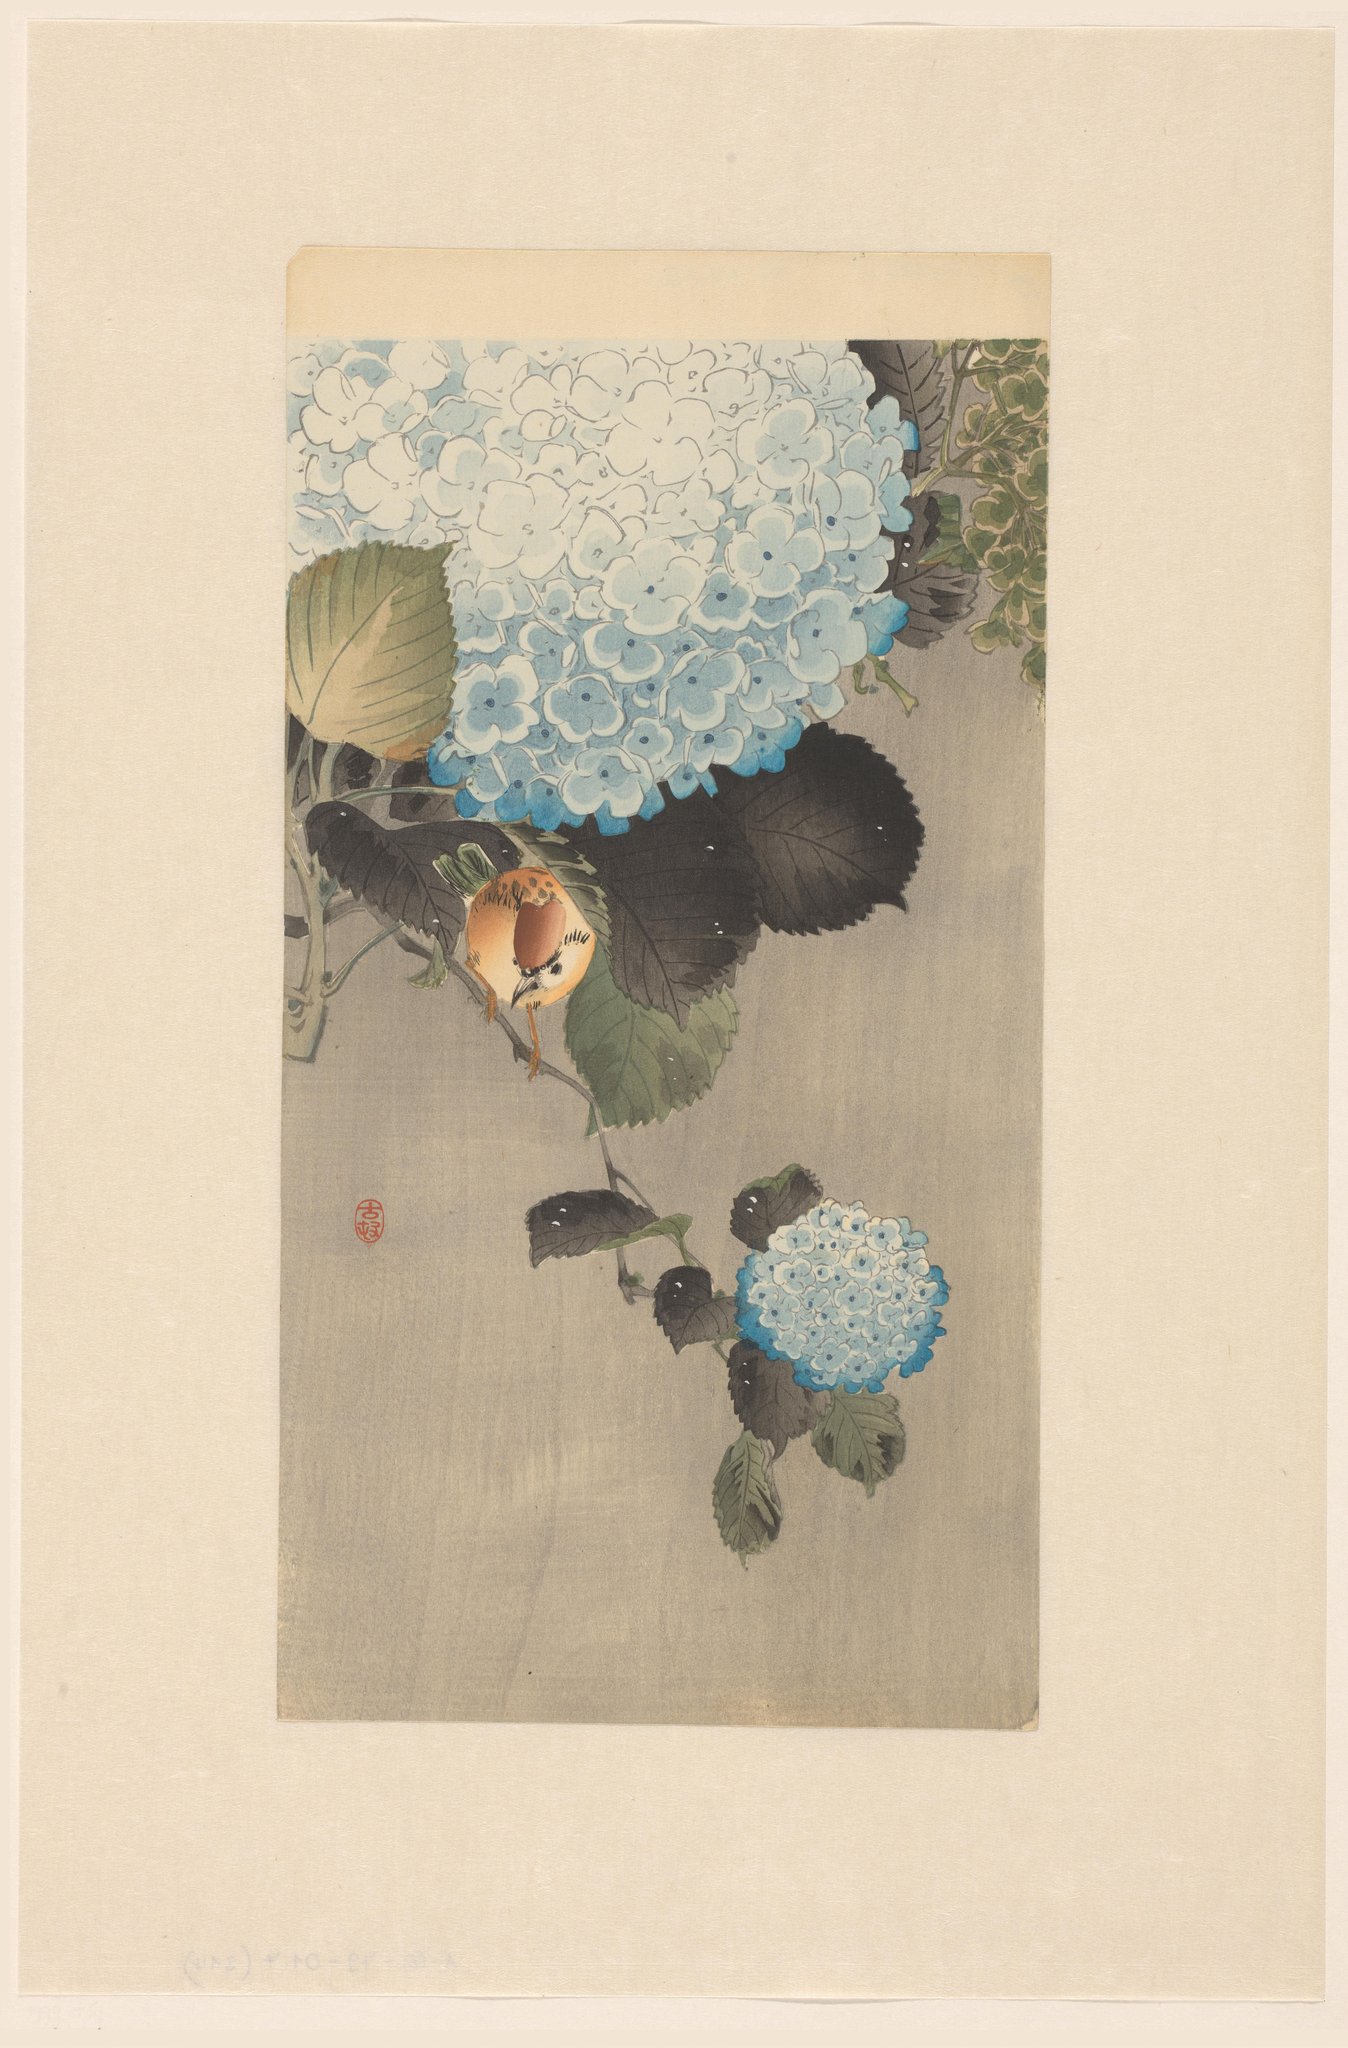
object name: print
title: Ringmus en hortensia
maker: ohara koson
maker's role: print maker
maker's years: 1877-1945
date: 1900-1930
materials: paper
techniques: woodcut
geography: japan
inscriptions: collector's mark: Lugt 2228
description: Ringmus op tak van bloeiende blauwe hortensia.